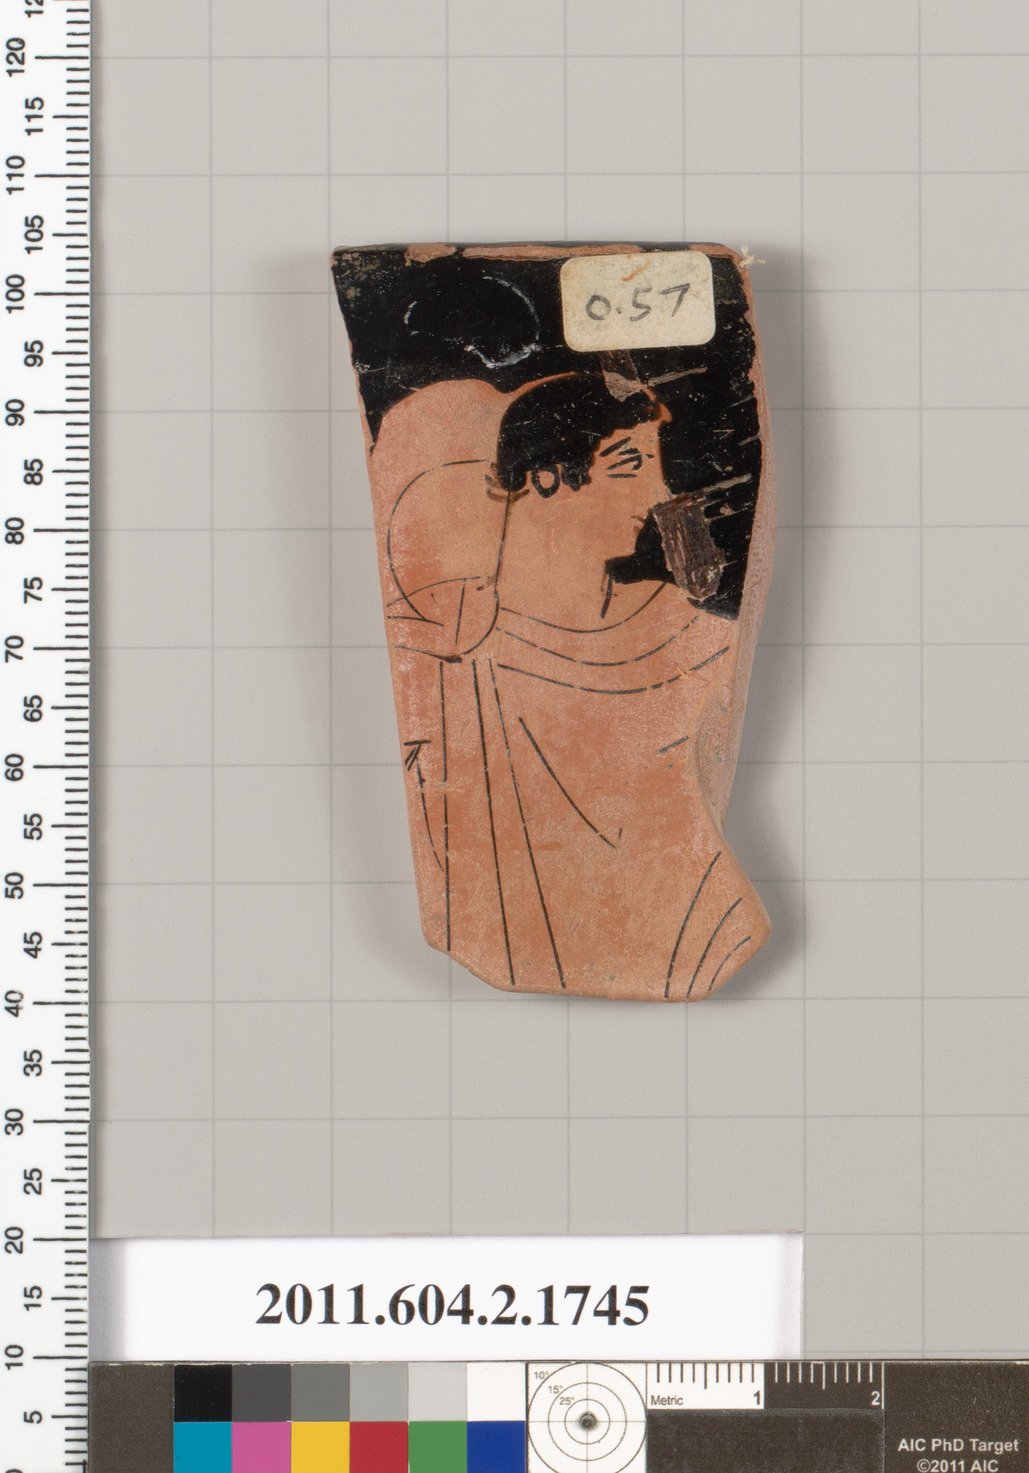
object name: skyphos fragment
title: Terracotta rim fragment of a skyphos (deep drinking cup)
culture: greek, attic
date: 450-426 BCE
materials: terracotta